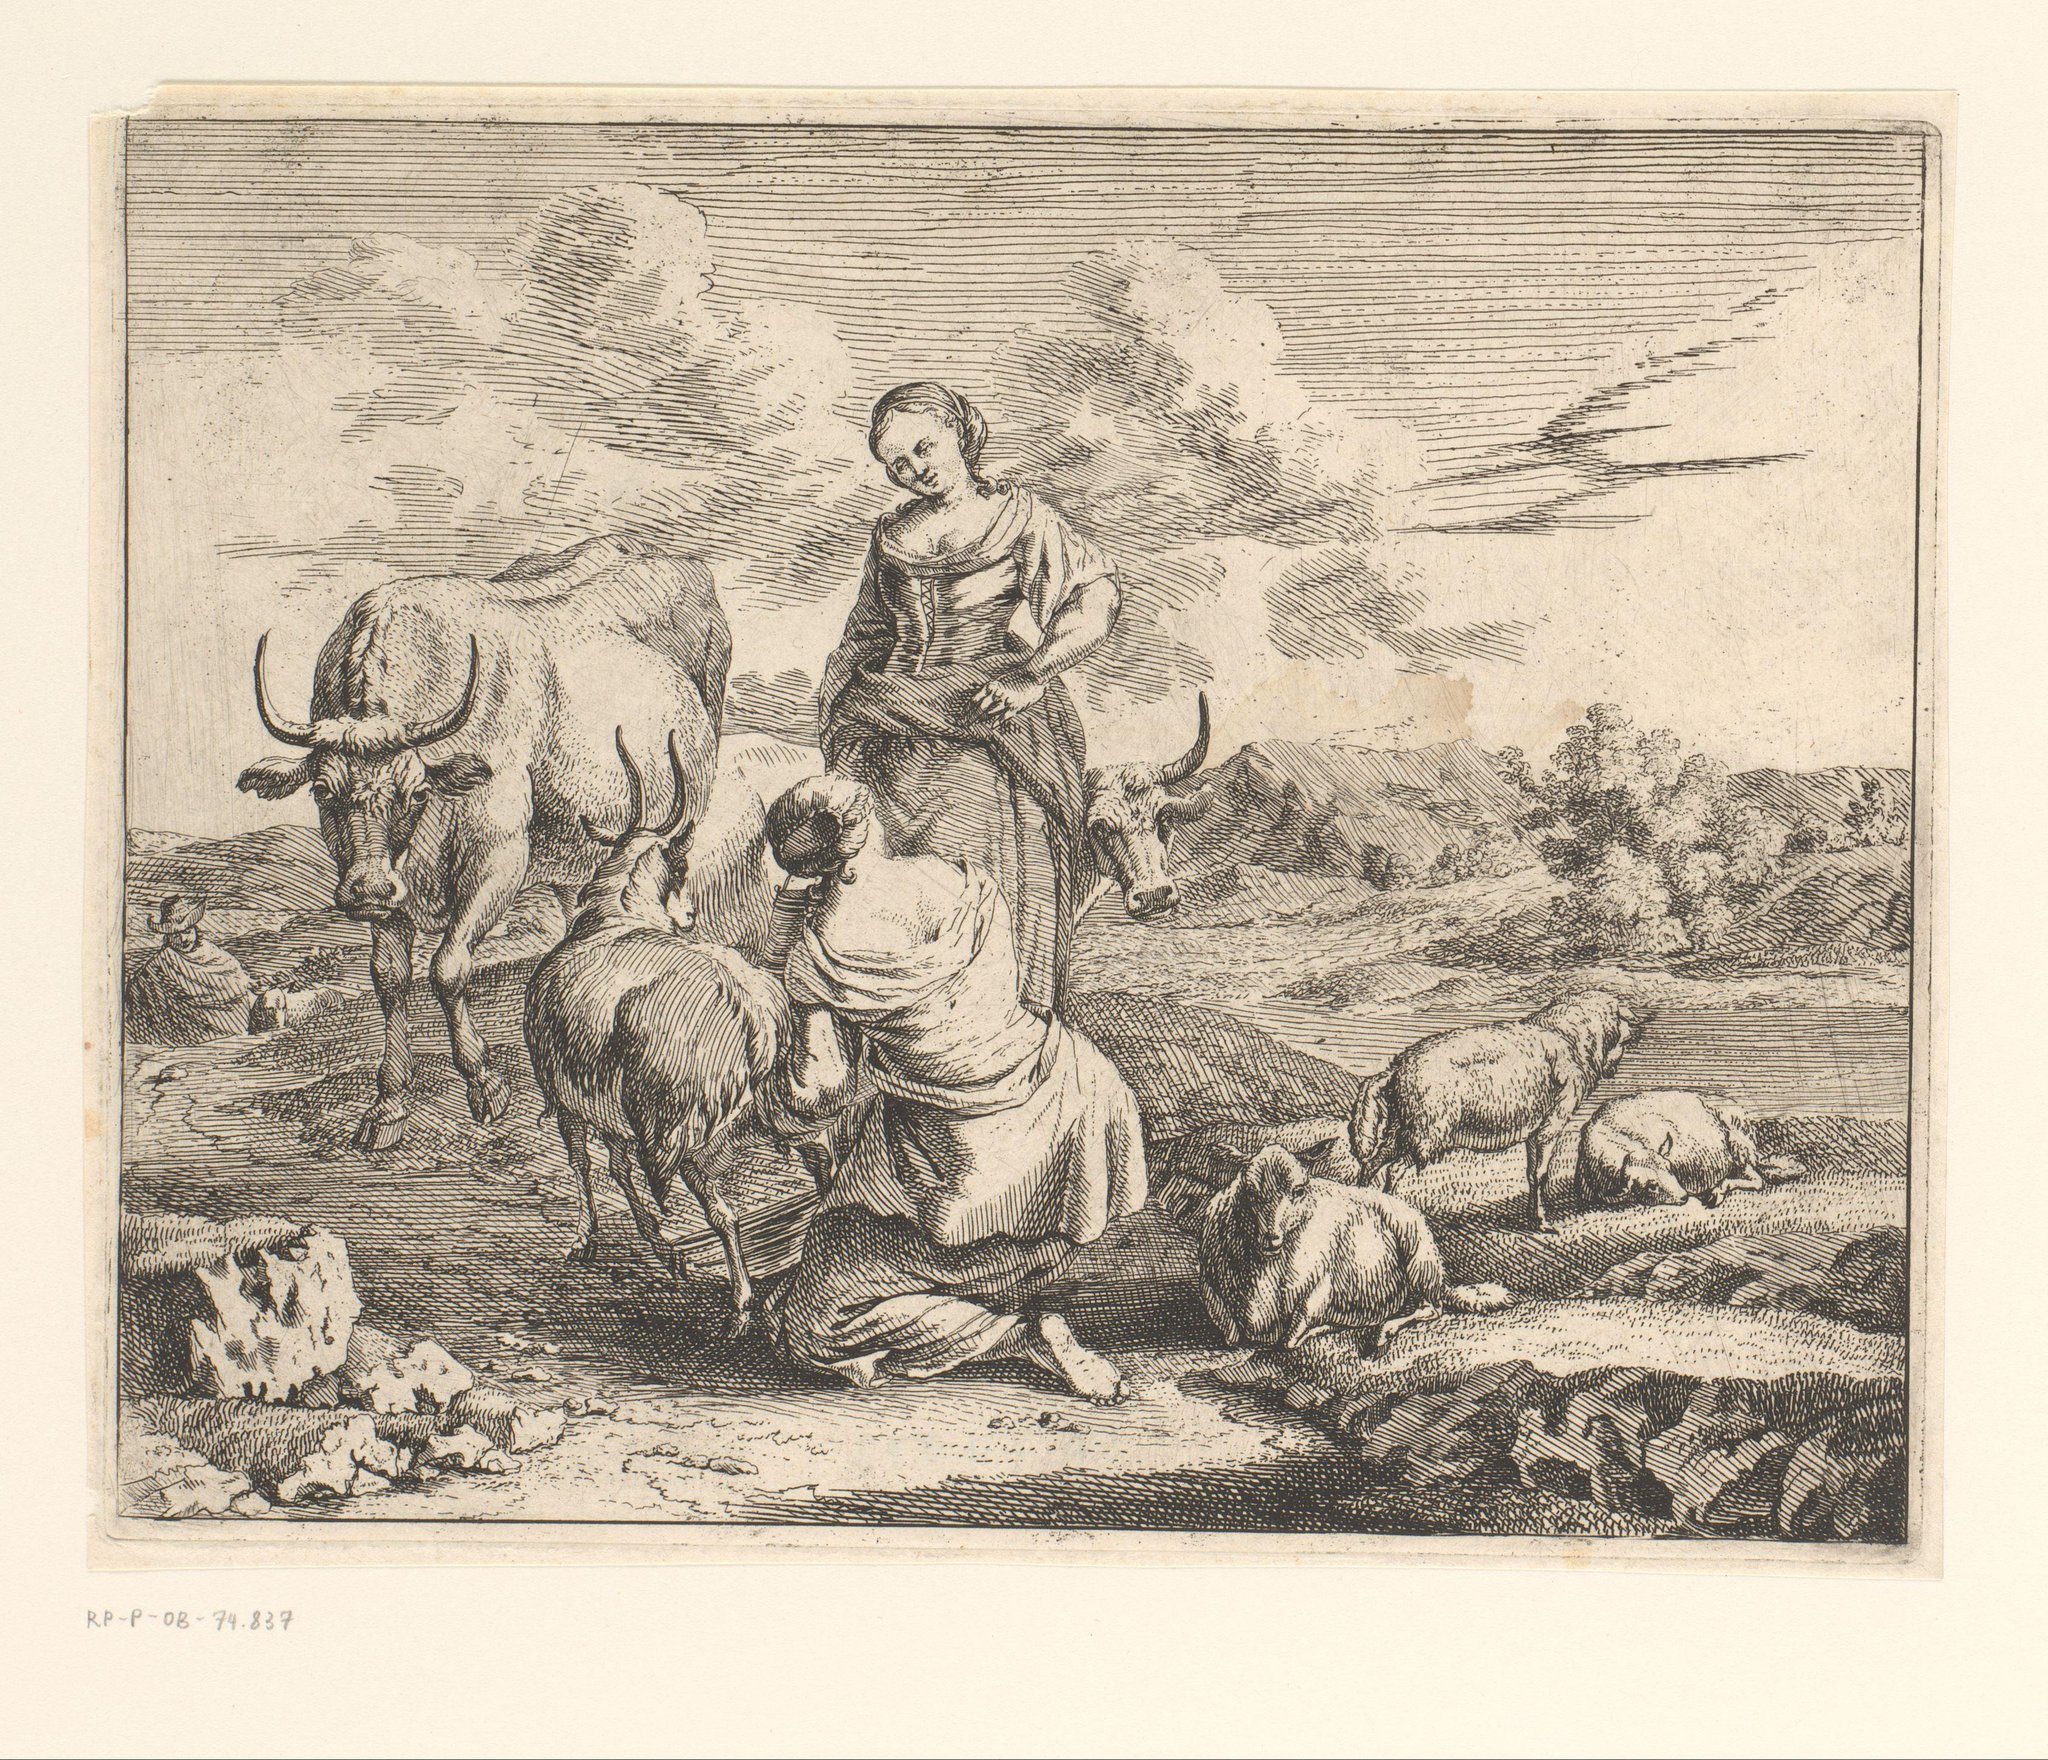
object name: print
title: Twee herderinnen met vee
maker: Anonymous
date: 1750-1800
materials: paper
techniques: engraving, etching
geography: france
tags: cattle driving, cattle driver, herd, flock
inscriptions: collector's mark: Lugt 240